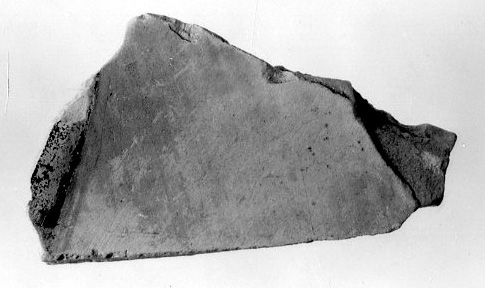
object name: relief fragment, tomb of meketre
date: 1981-1975 BCE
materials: limestone, paint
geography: egypt